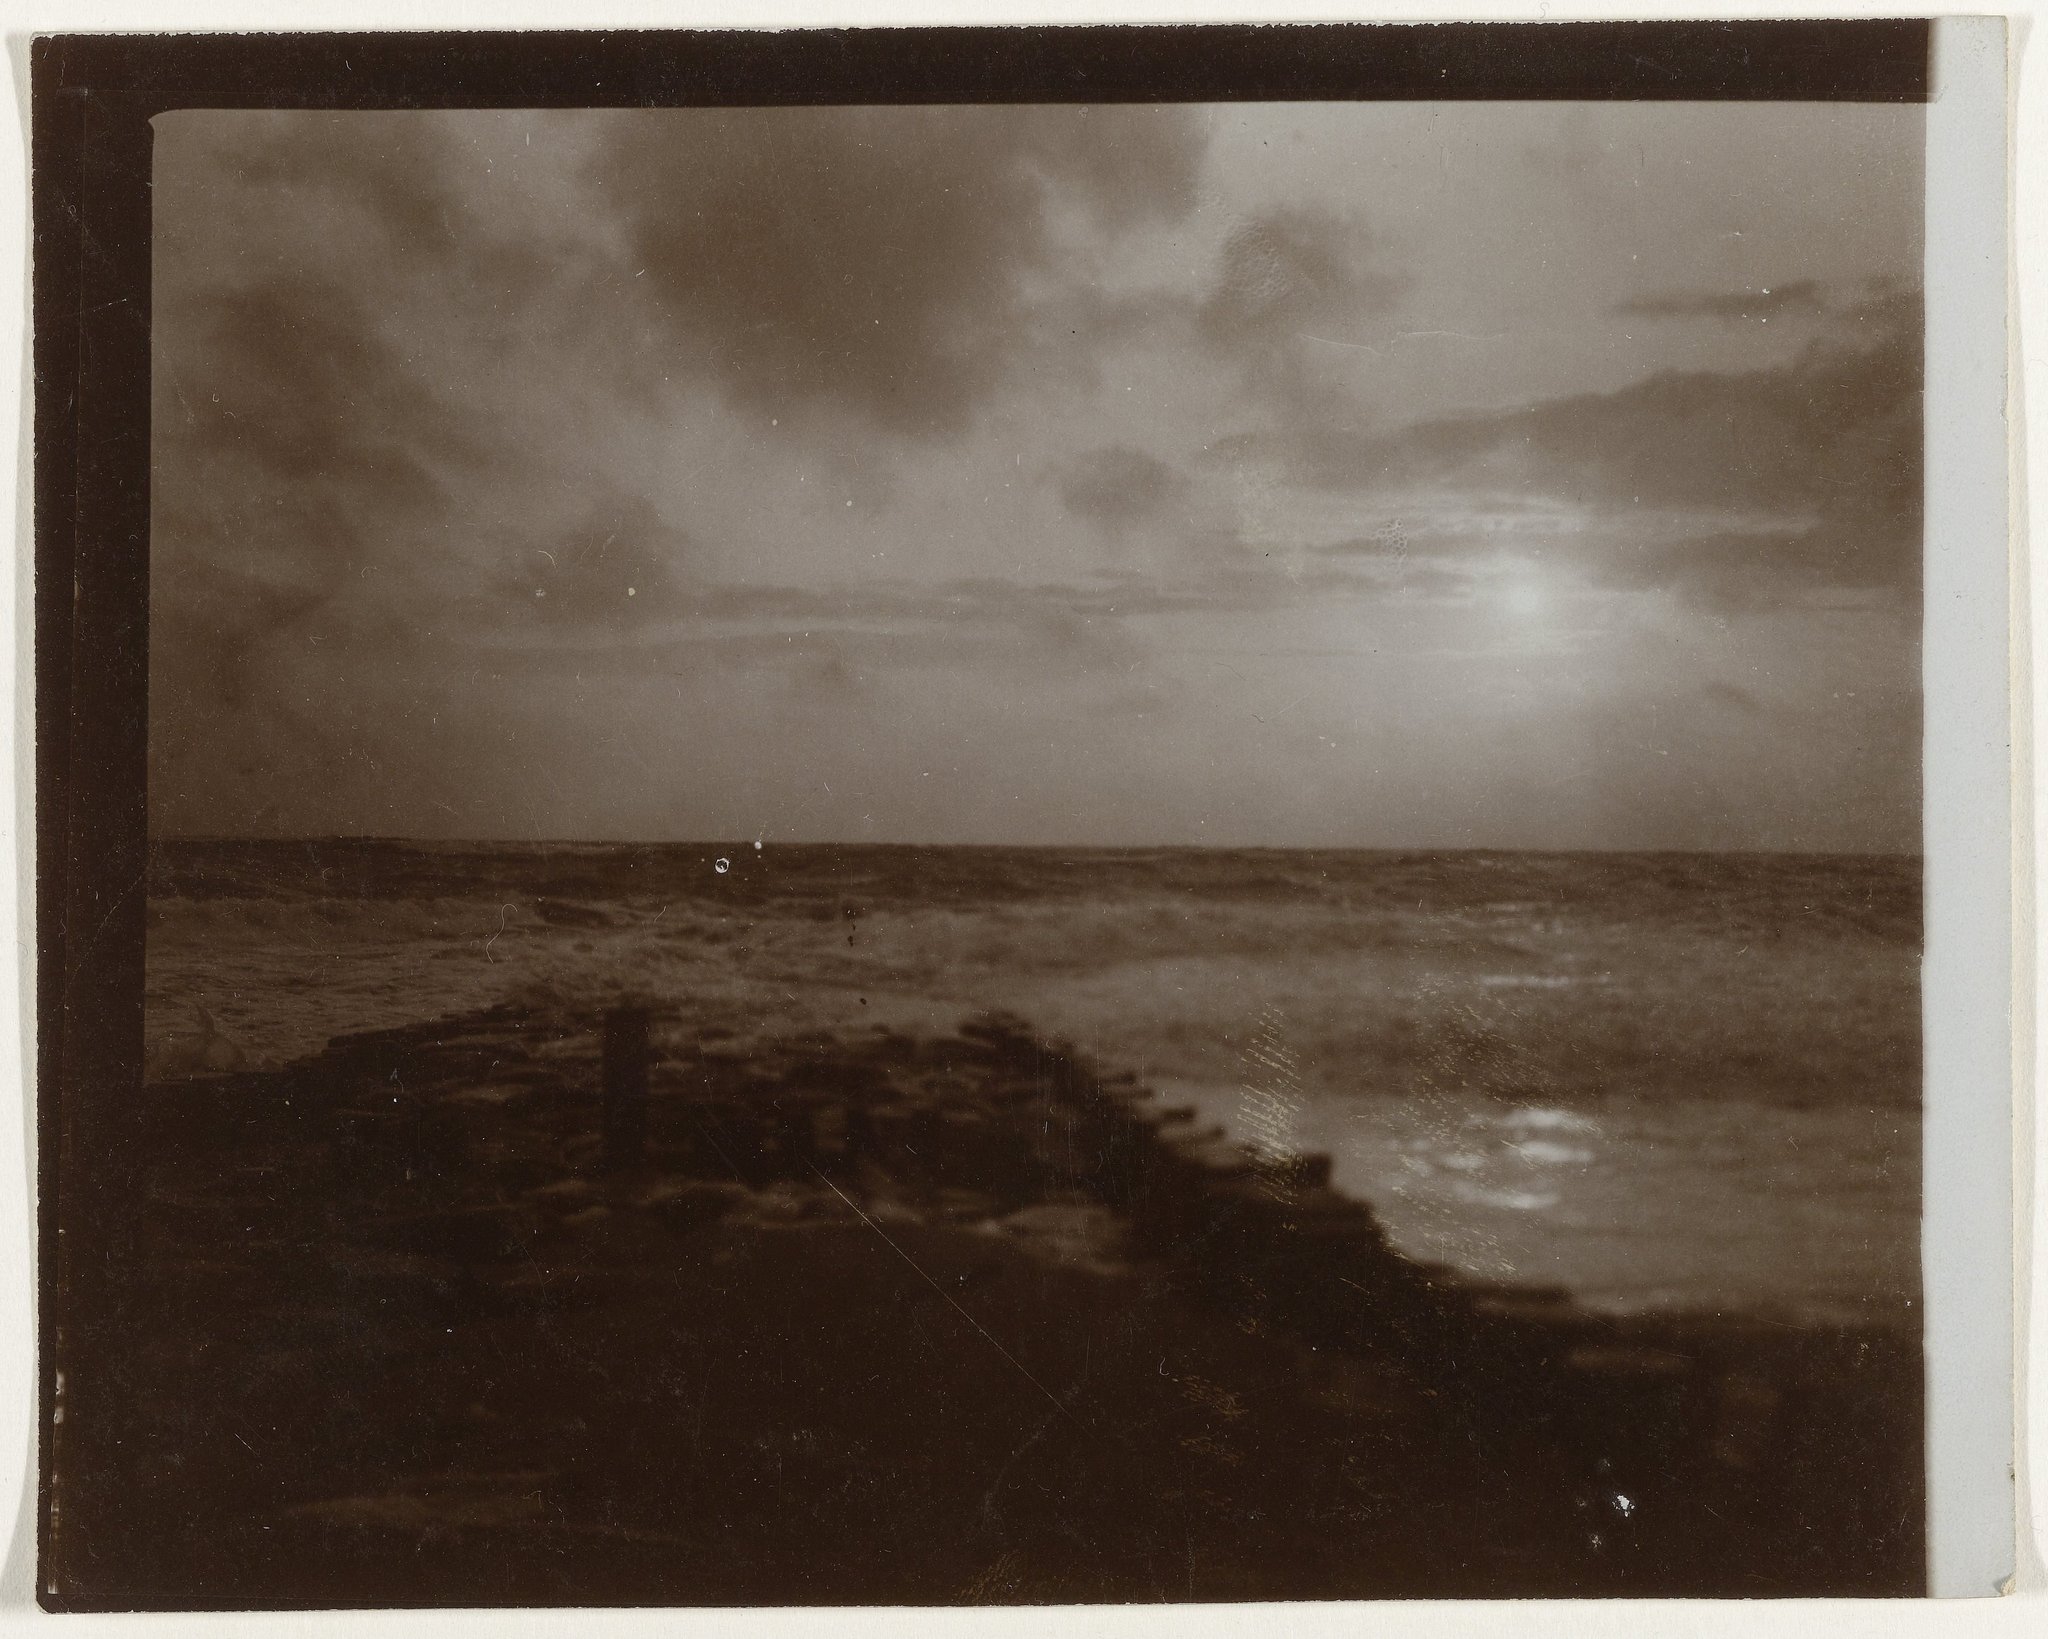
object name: photograph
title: Pier aan zee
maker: Anonymous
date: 1900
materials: paper, photographic support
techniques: collodion silver print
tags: pier, quay, wharf, coast